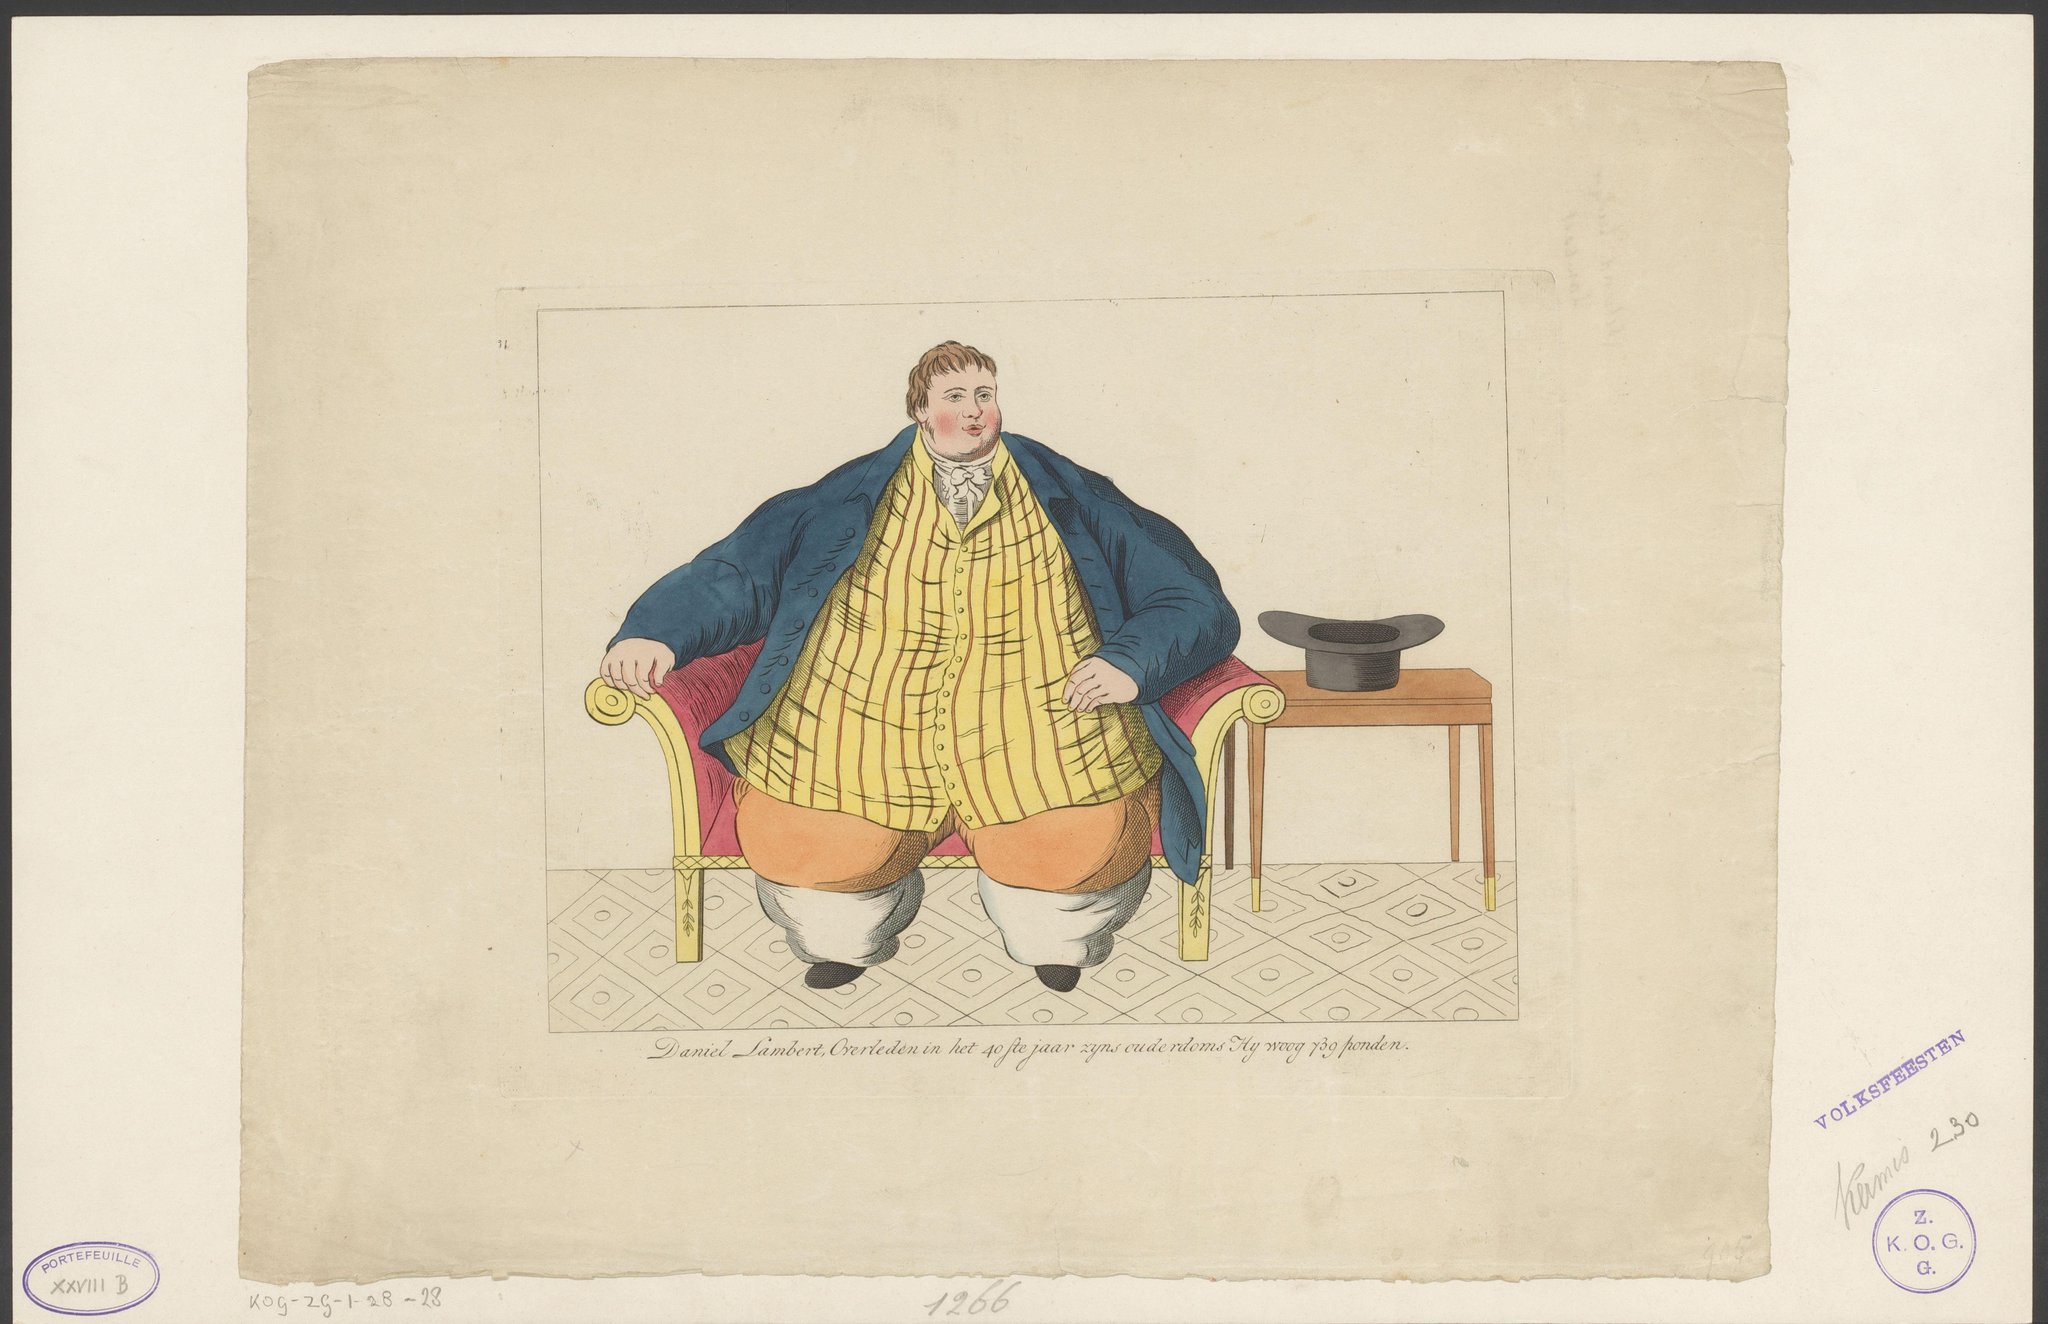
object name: print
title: Daniel Lambert, Overleden in het 40 ste jaar zijns ouderdoms Hij woog 739 ponden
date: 1809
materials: paper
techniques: engraving, etching, hand coloring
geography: amsterdam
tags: clothing for the upper part of the body (vest) (+ men's clothes), fat (human type), coat (+ men's clothes), head-gear: hat (+ men's clothes), fashion plates, trousers, breeches, etc. (breeches) (+ men's clothes), couch, sofa, settee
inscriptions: collector's mark: Lugt 1641, stamp, stamp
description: Daniel Lambert zittend op een bank, overleden op 40-jarige leeftijd. Op dat moment woog hij 739 pond. Onderwerpsrubrieken binnen de Atlas Zeden en Gewoonten: Zeden en Gewoonten in Engeren Zin. Volksleven. Volksfeesten. Kermistypen, wondermenschen en dergelijken.